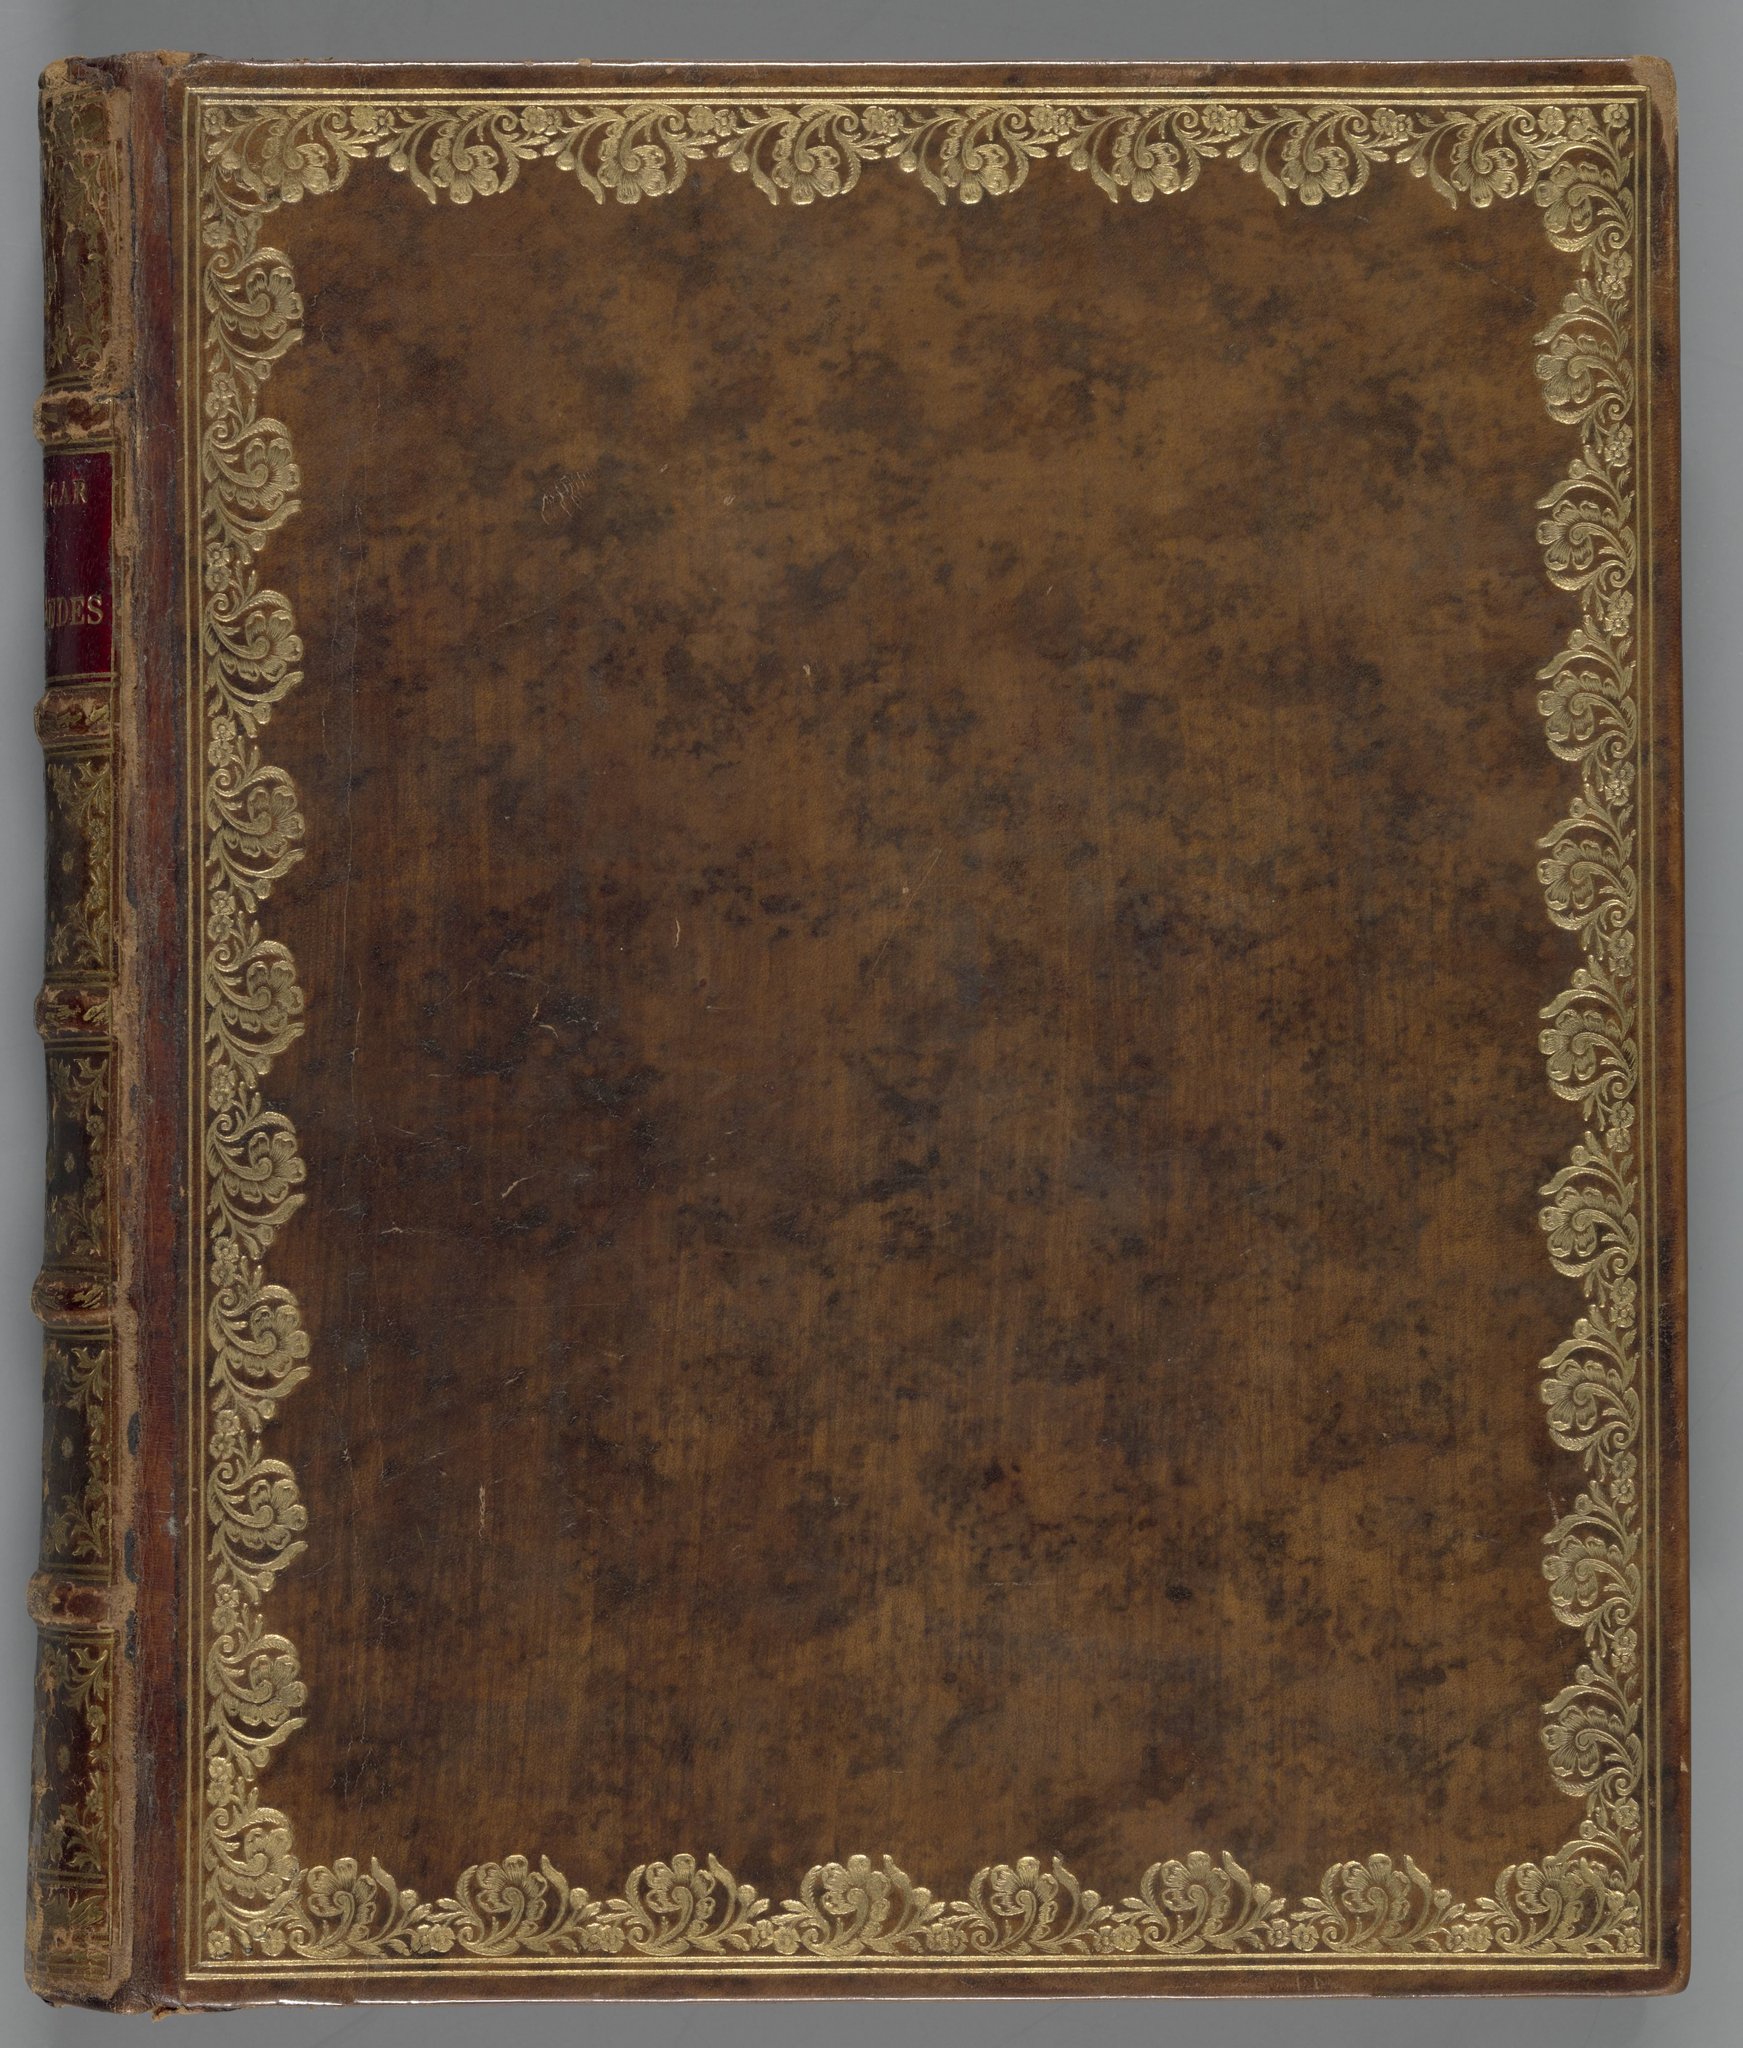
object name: book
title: Album van Jan Brandes, deel 2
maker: jan brandes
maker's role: draughtsman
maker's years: 1743-1808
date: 1910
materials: cardboard, paint, paper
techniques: bookbinding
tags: bodegraven, draughtsman, jan brandes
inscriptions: inscription: ‘TECKNINGAR / AF / JAN BRANDES / II’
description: Album Jan Brandes waarin 146 tekeningen zijn ingebonden. Voor- en achterkaft bruin-zwart gevlekt voorzien van gouden kader met bladermotief. Rug met vijf ribbels, gouden versiering en opdruk. Binnenkant album v.z.v. geemailleerde schutbladen en kapitaalbandjes. Album samen met album NG-1985-7-1 in gebloemde kartonnen casette, van binnen wit gestoffeerd.